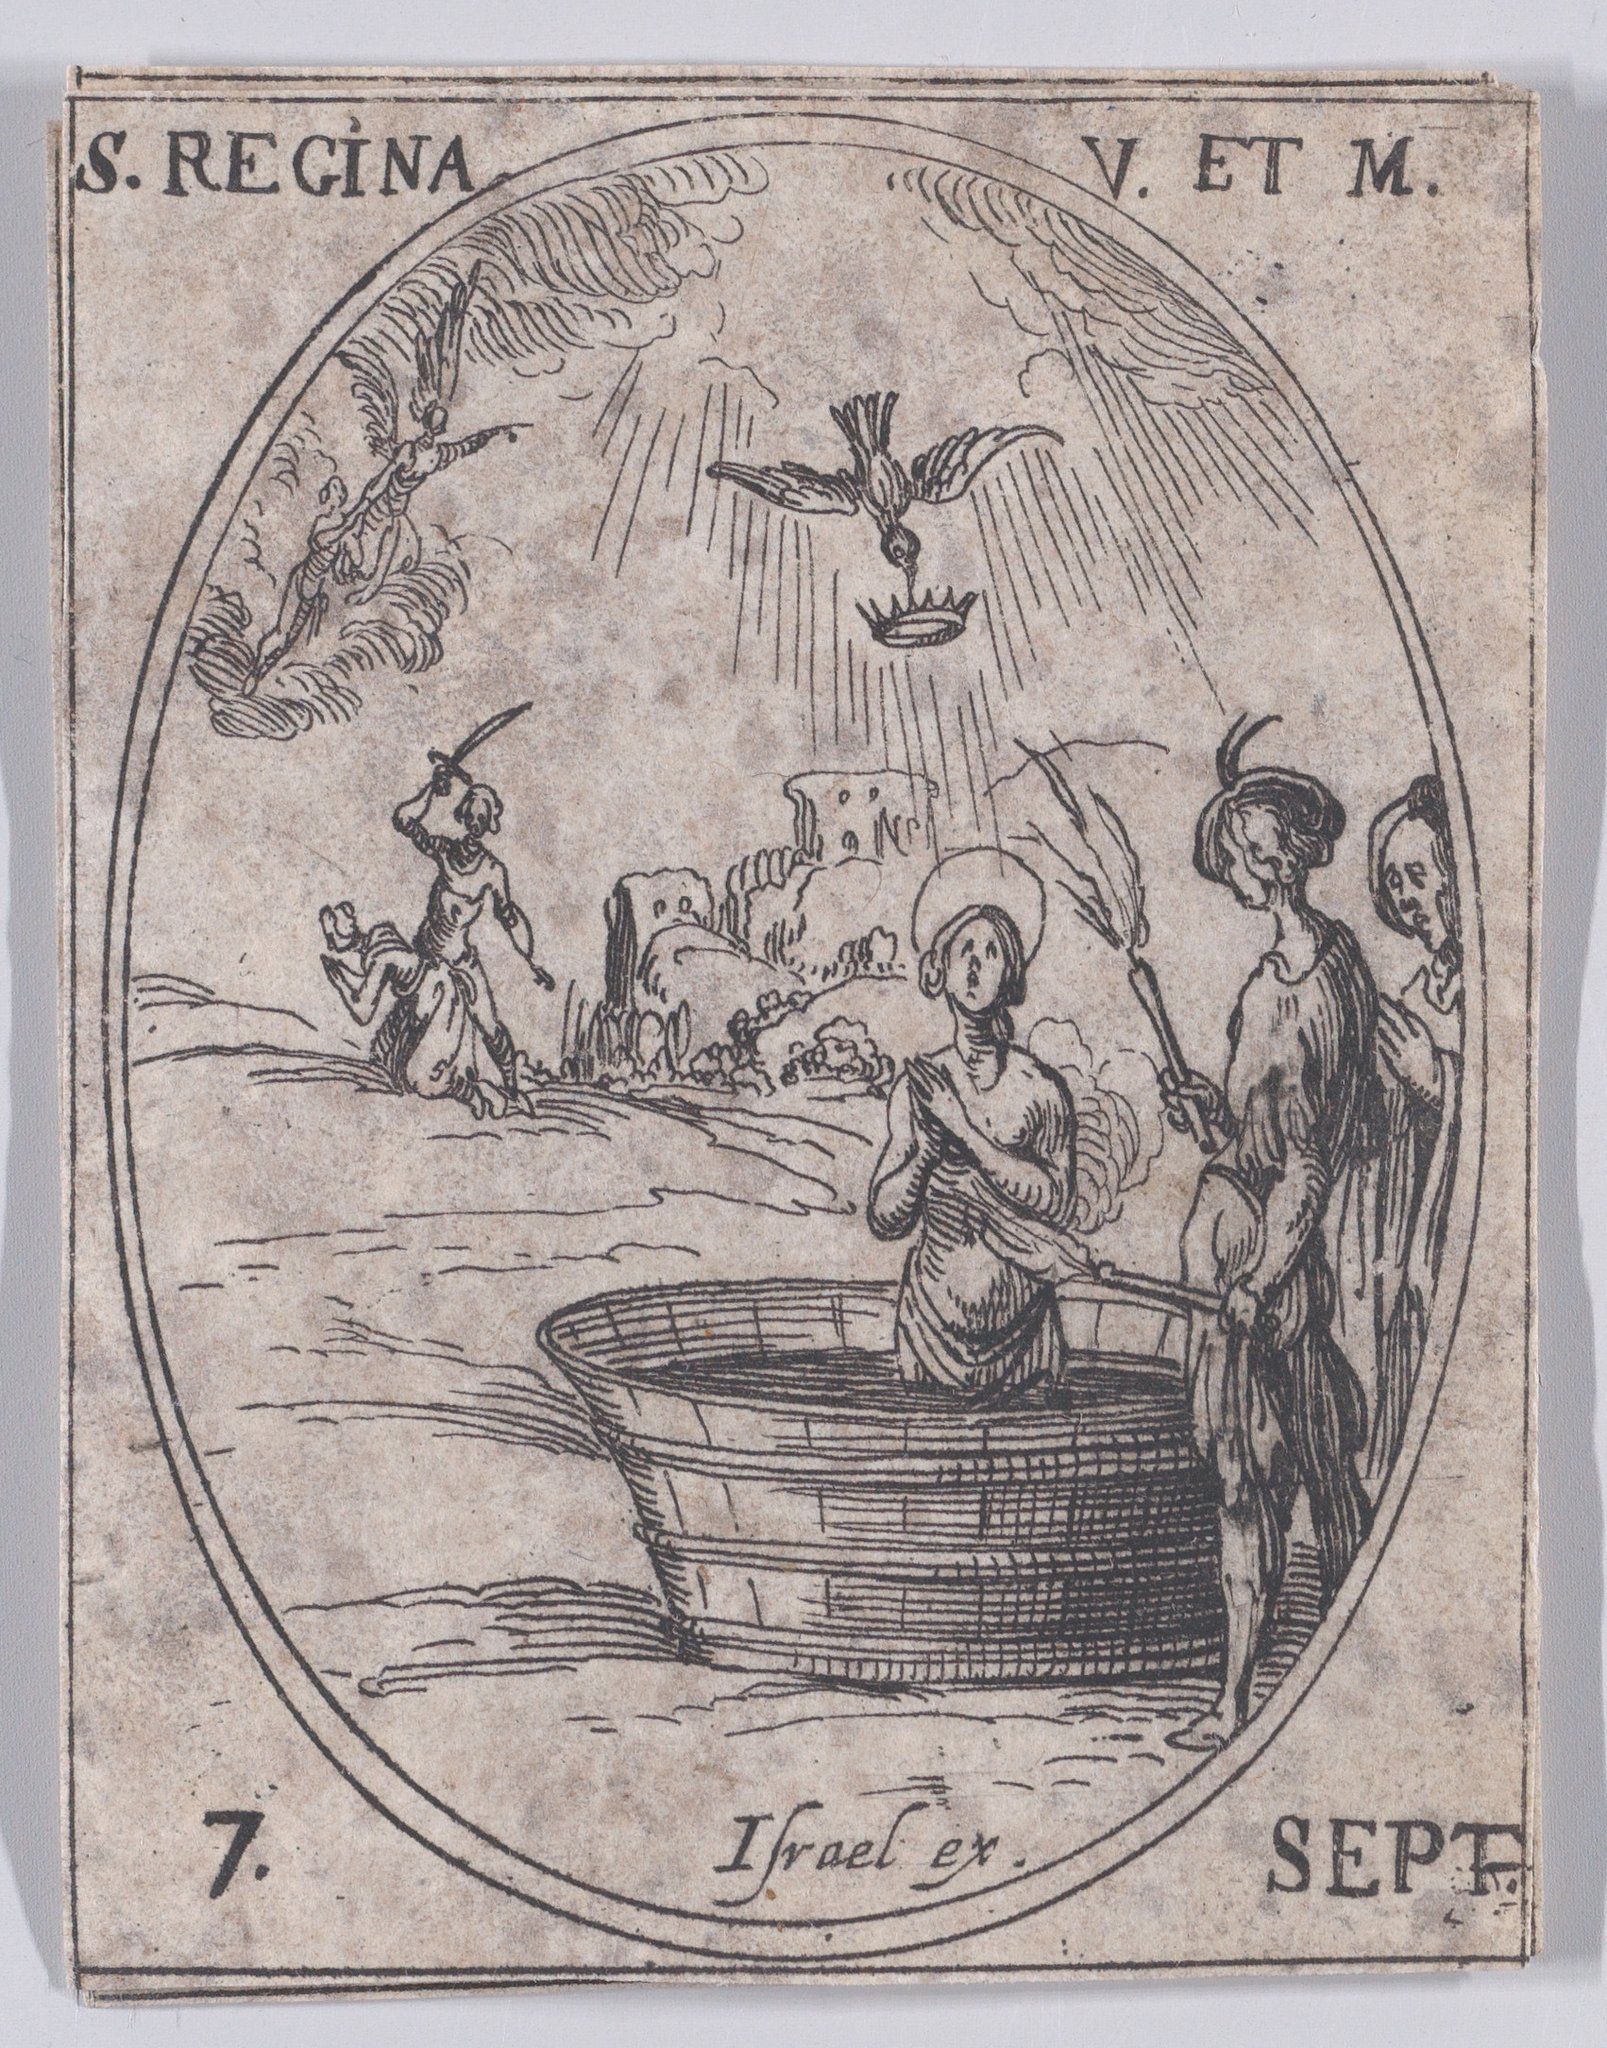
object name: print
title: Ste. Reine, vierge et martyre (St. Regina, Virgin and Martyr), September 7th, from "Les Images De Tous Les Saincts et Saintes de L'Année" (Images of All of the Saints and Religious Events of the Year)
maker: jacques callot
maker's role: artist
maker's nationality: french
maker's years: 1592-1635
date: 1636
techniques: etching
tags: women,saints